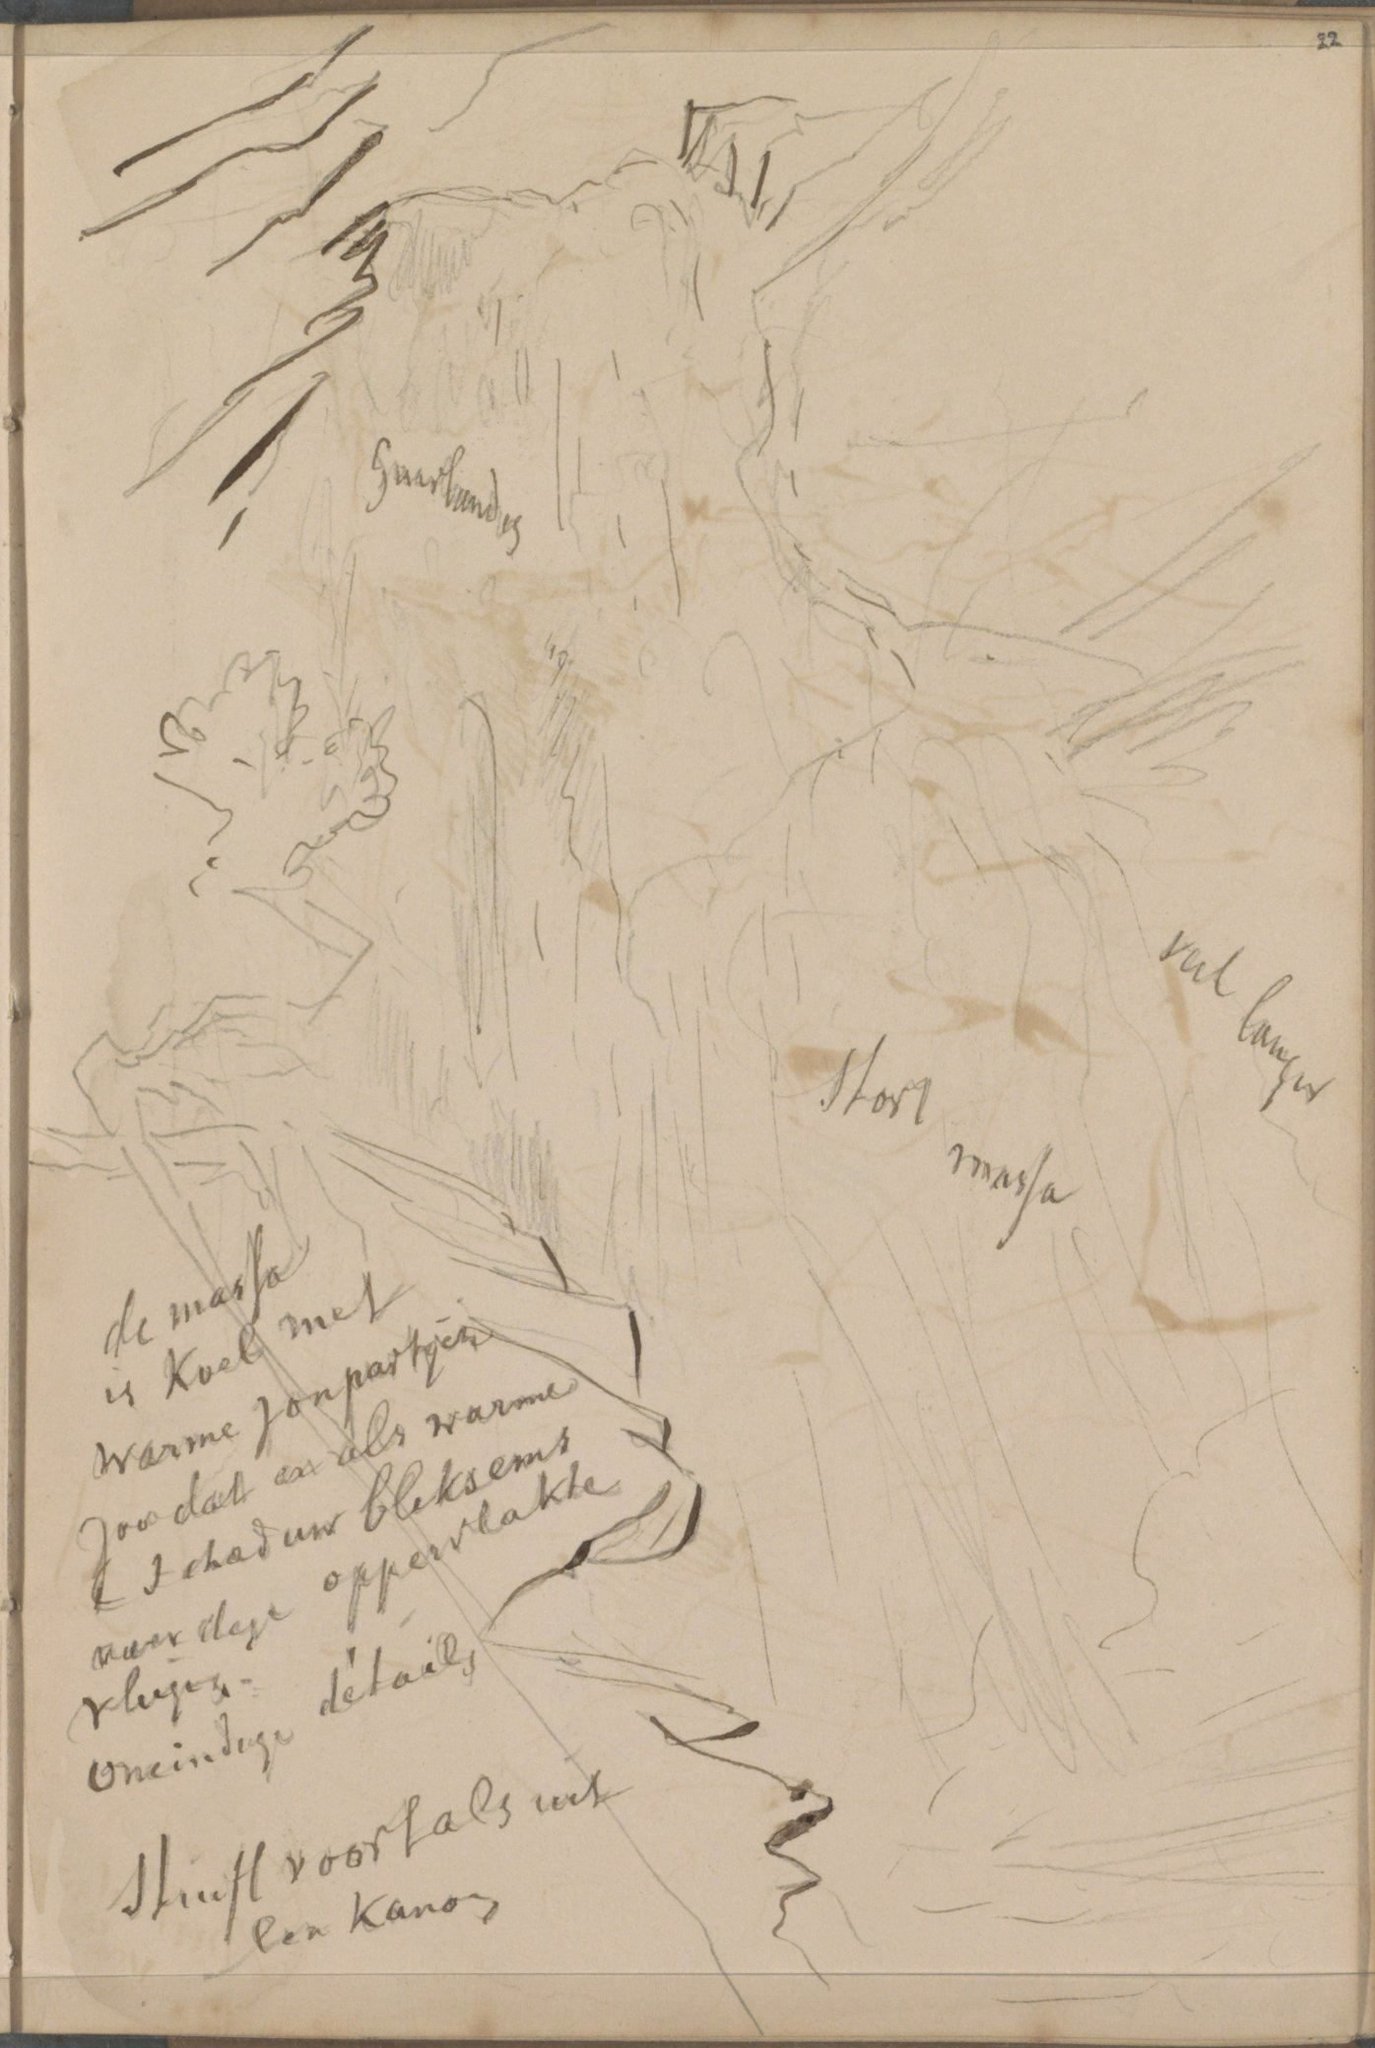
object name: sketchbook leaf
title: Waterval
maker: johannes tavenraat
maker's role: draughtsman, painter, print maker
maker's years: 1809-1881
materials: ink, paper, pencil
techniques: pen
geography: krimml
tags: waterfall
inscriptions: kleurnotitie, handgeschreven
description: Blad 22 recto uit een schetsboek met 47 bladen.